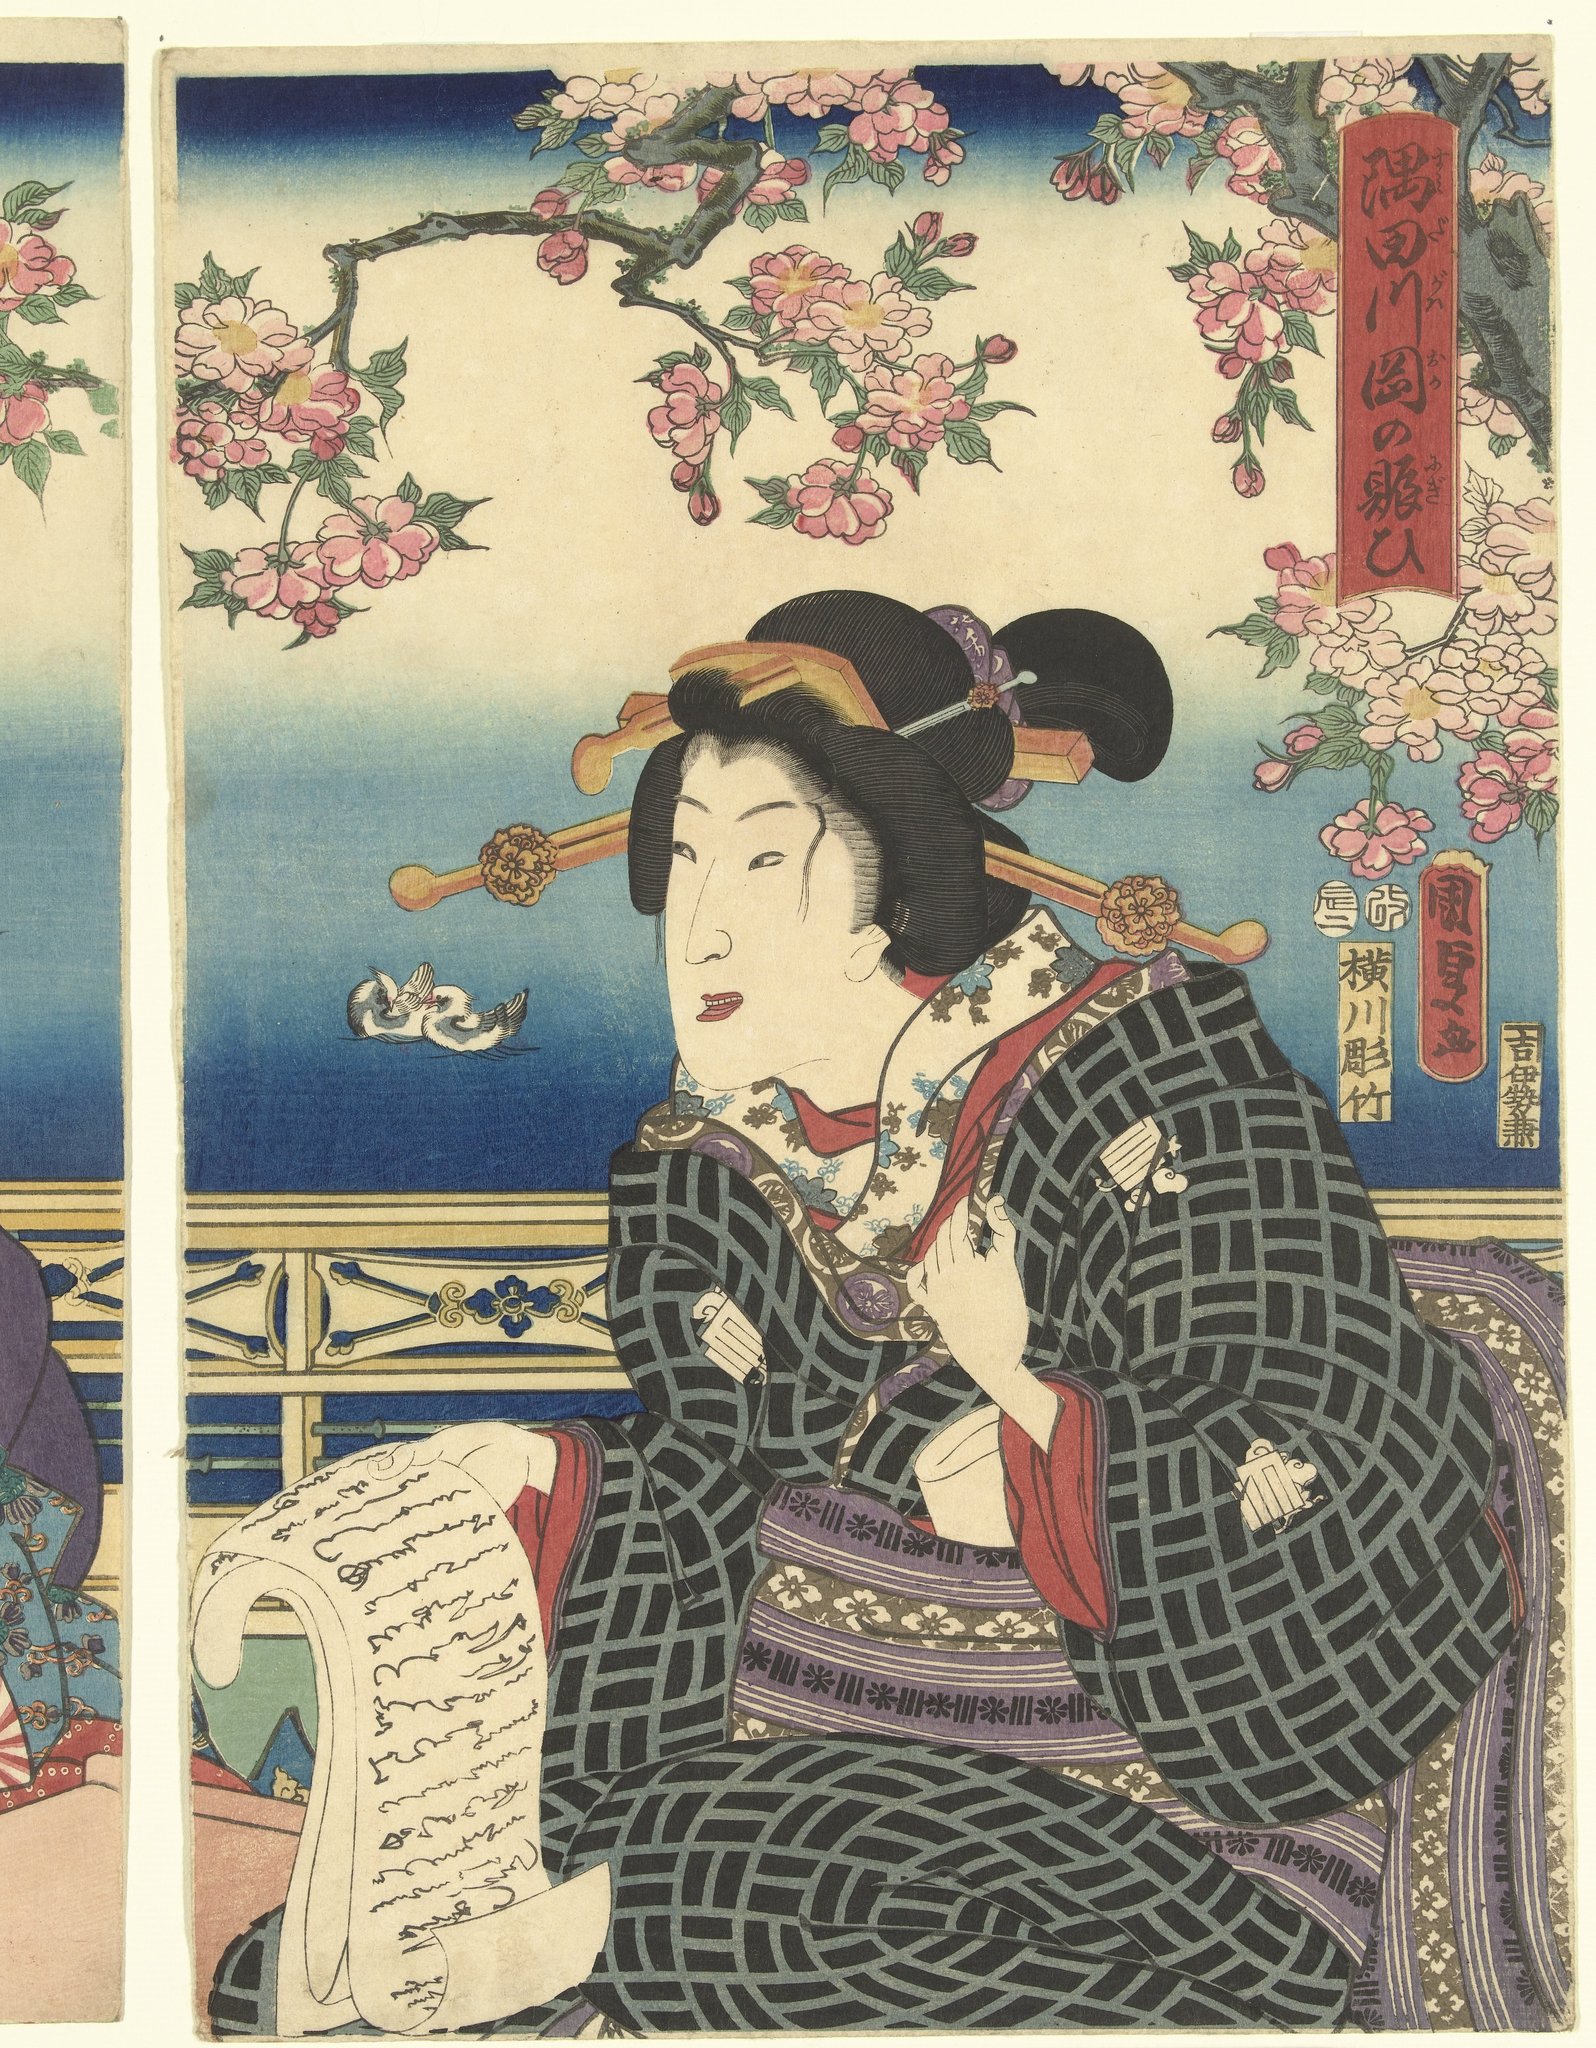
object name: print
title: Voorspoed in de bergen langs de Sumida rivier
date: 1802-1856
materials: paper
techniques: woodcut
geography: japan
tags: adult woman, river, letter, envelope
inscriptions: date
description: Vrouw met brief in rechter hand, zittend op een veranda, onder kersenbloesemtakken, aan een rivier waarin twee eenden.